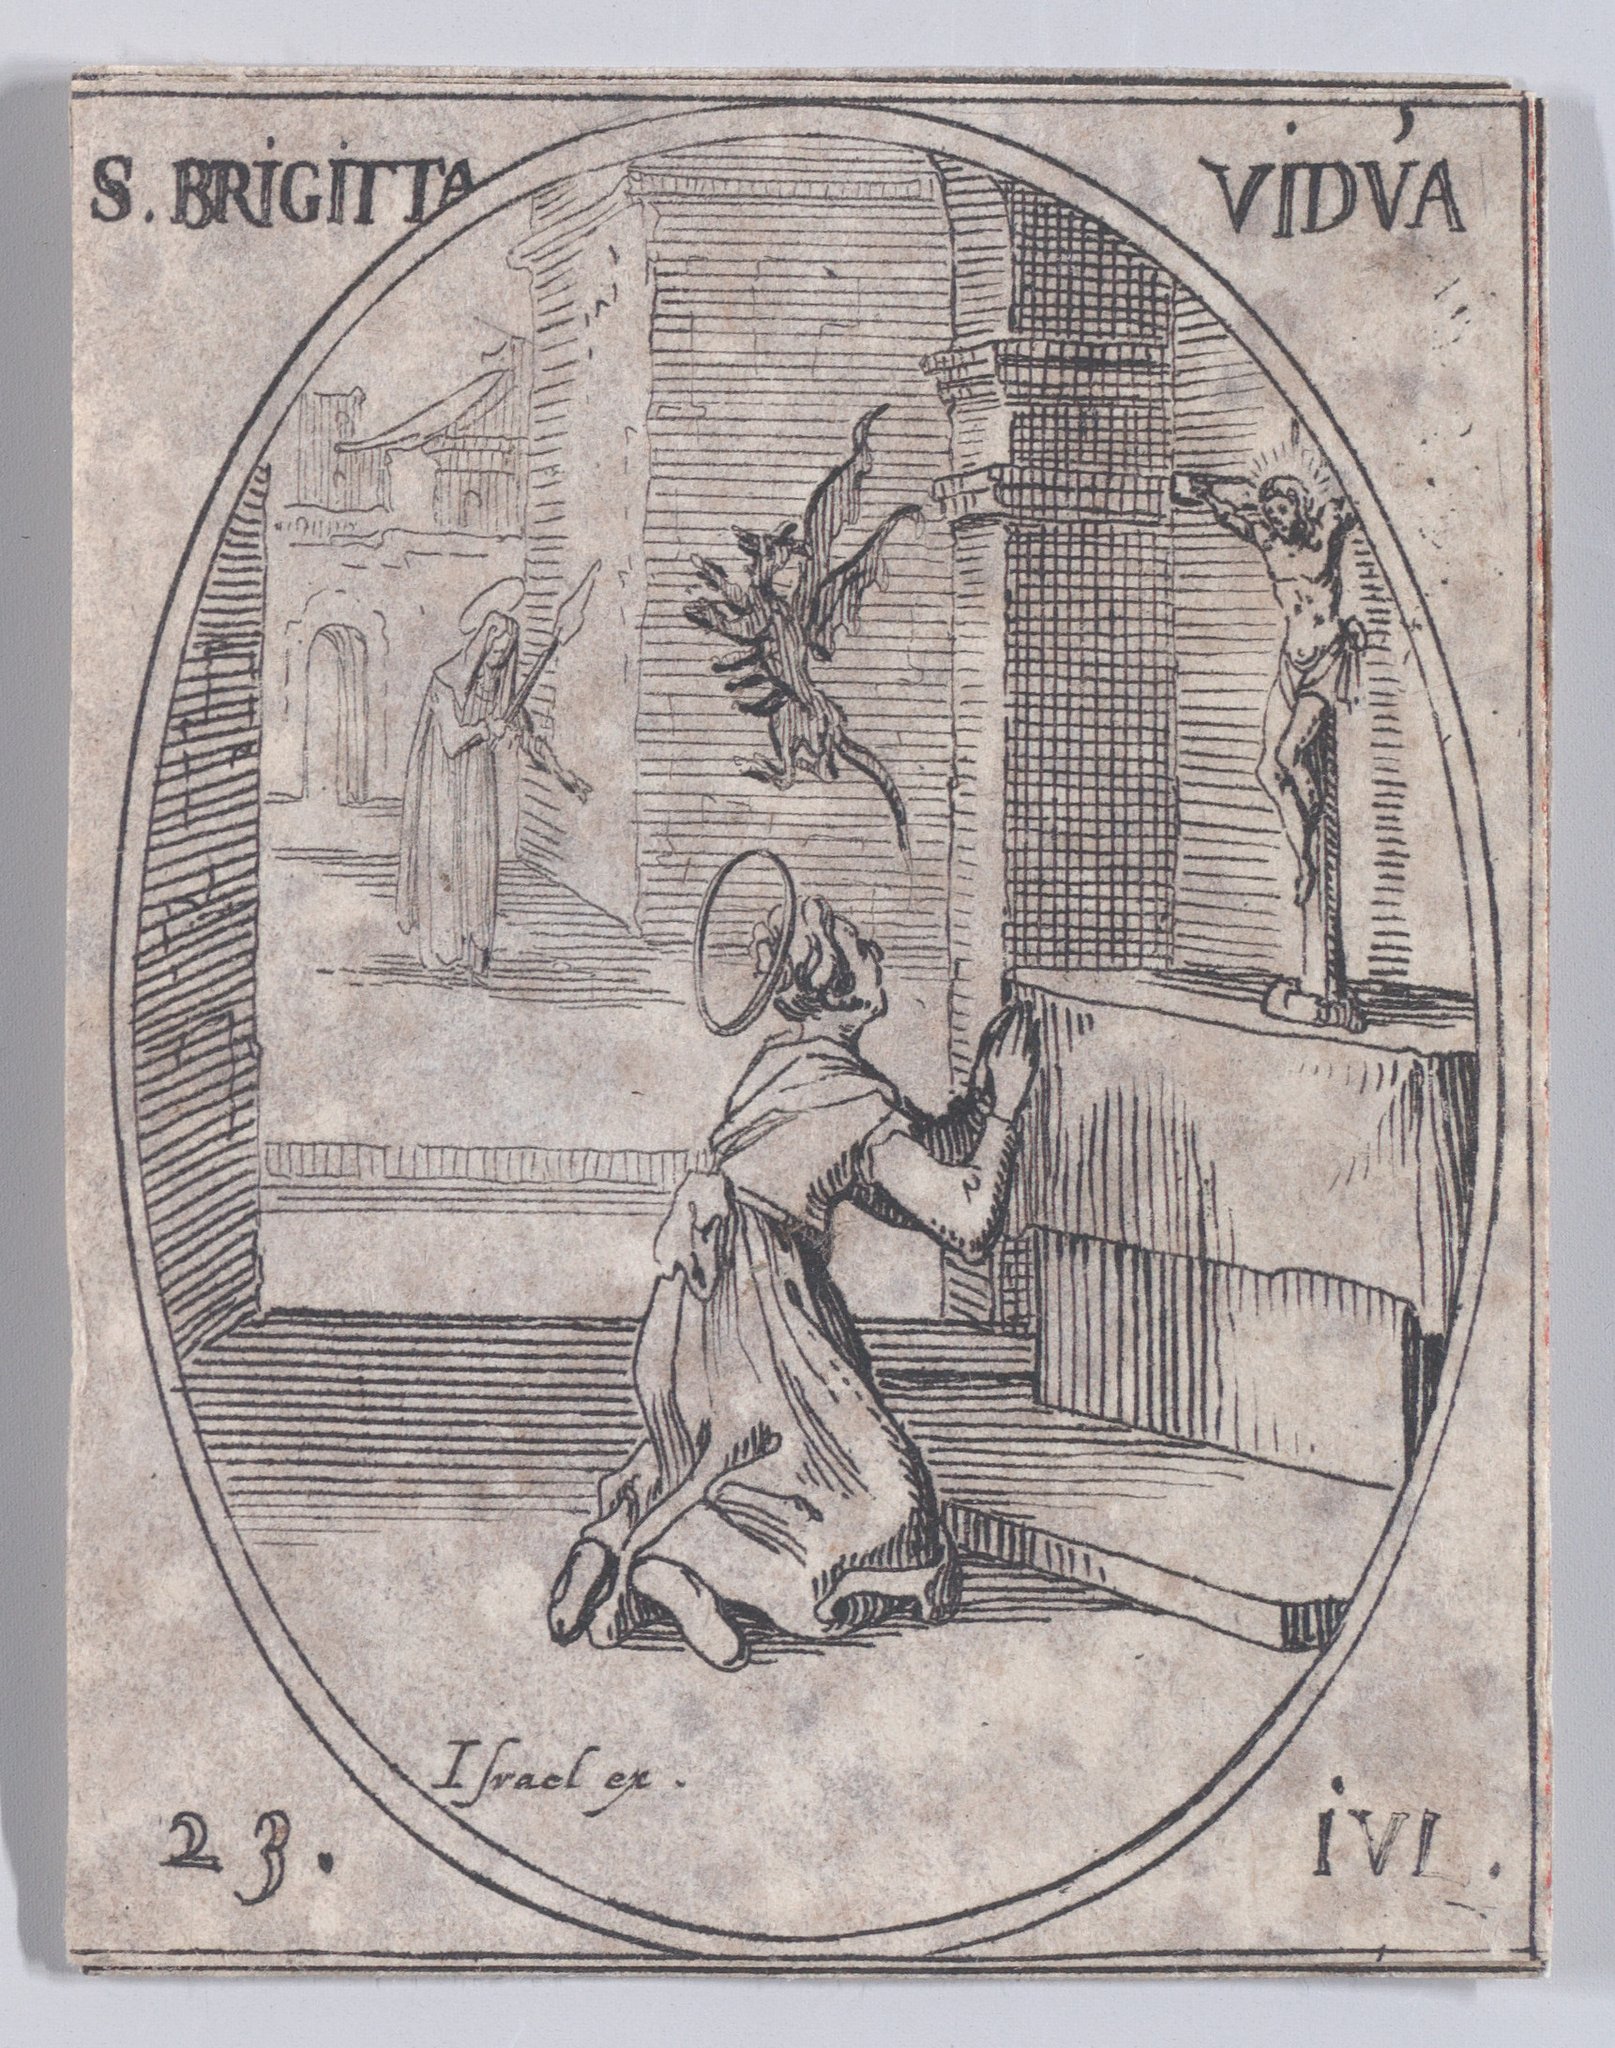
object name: print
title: Ste. Brigitte de Suède, veuve (St. Bridget of Sweden, Widow), July 23rd, from "Les Images De Tous Les Saincts et Saintes de L'Année" (Images of All of the Saints and Religious Events of the Year)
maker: jacques callot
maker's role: artist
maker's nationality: french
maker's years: 1592-1635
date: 1636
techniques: etching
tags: altars,men,saints